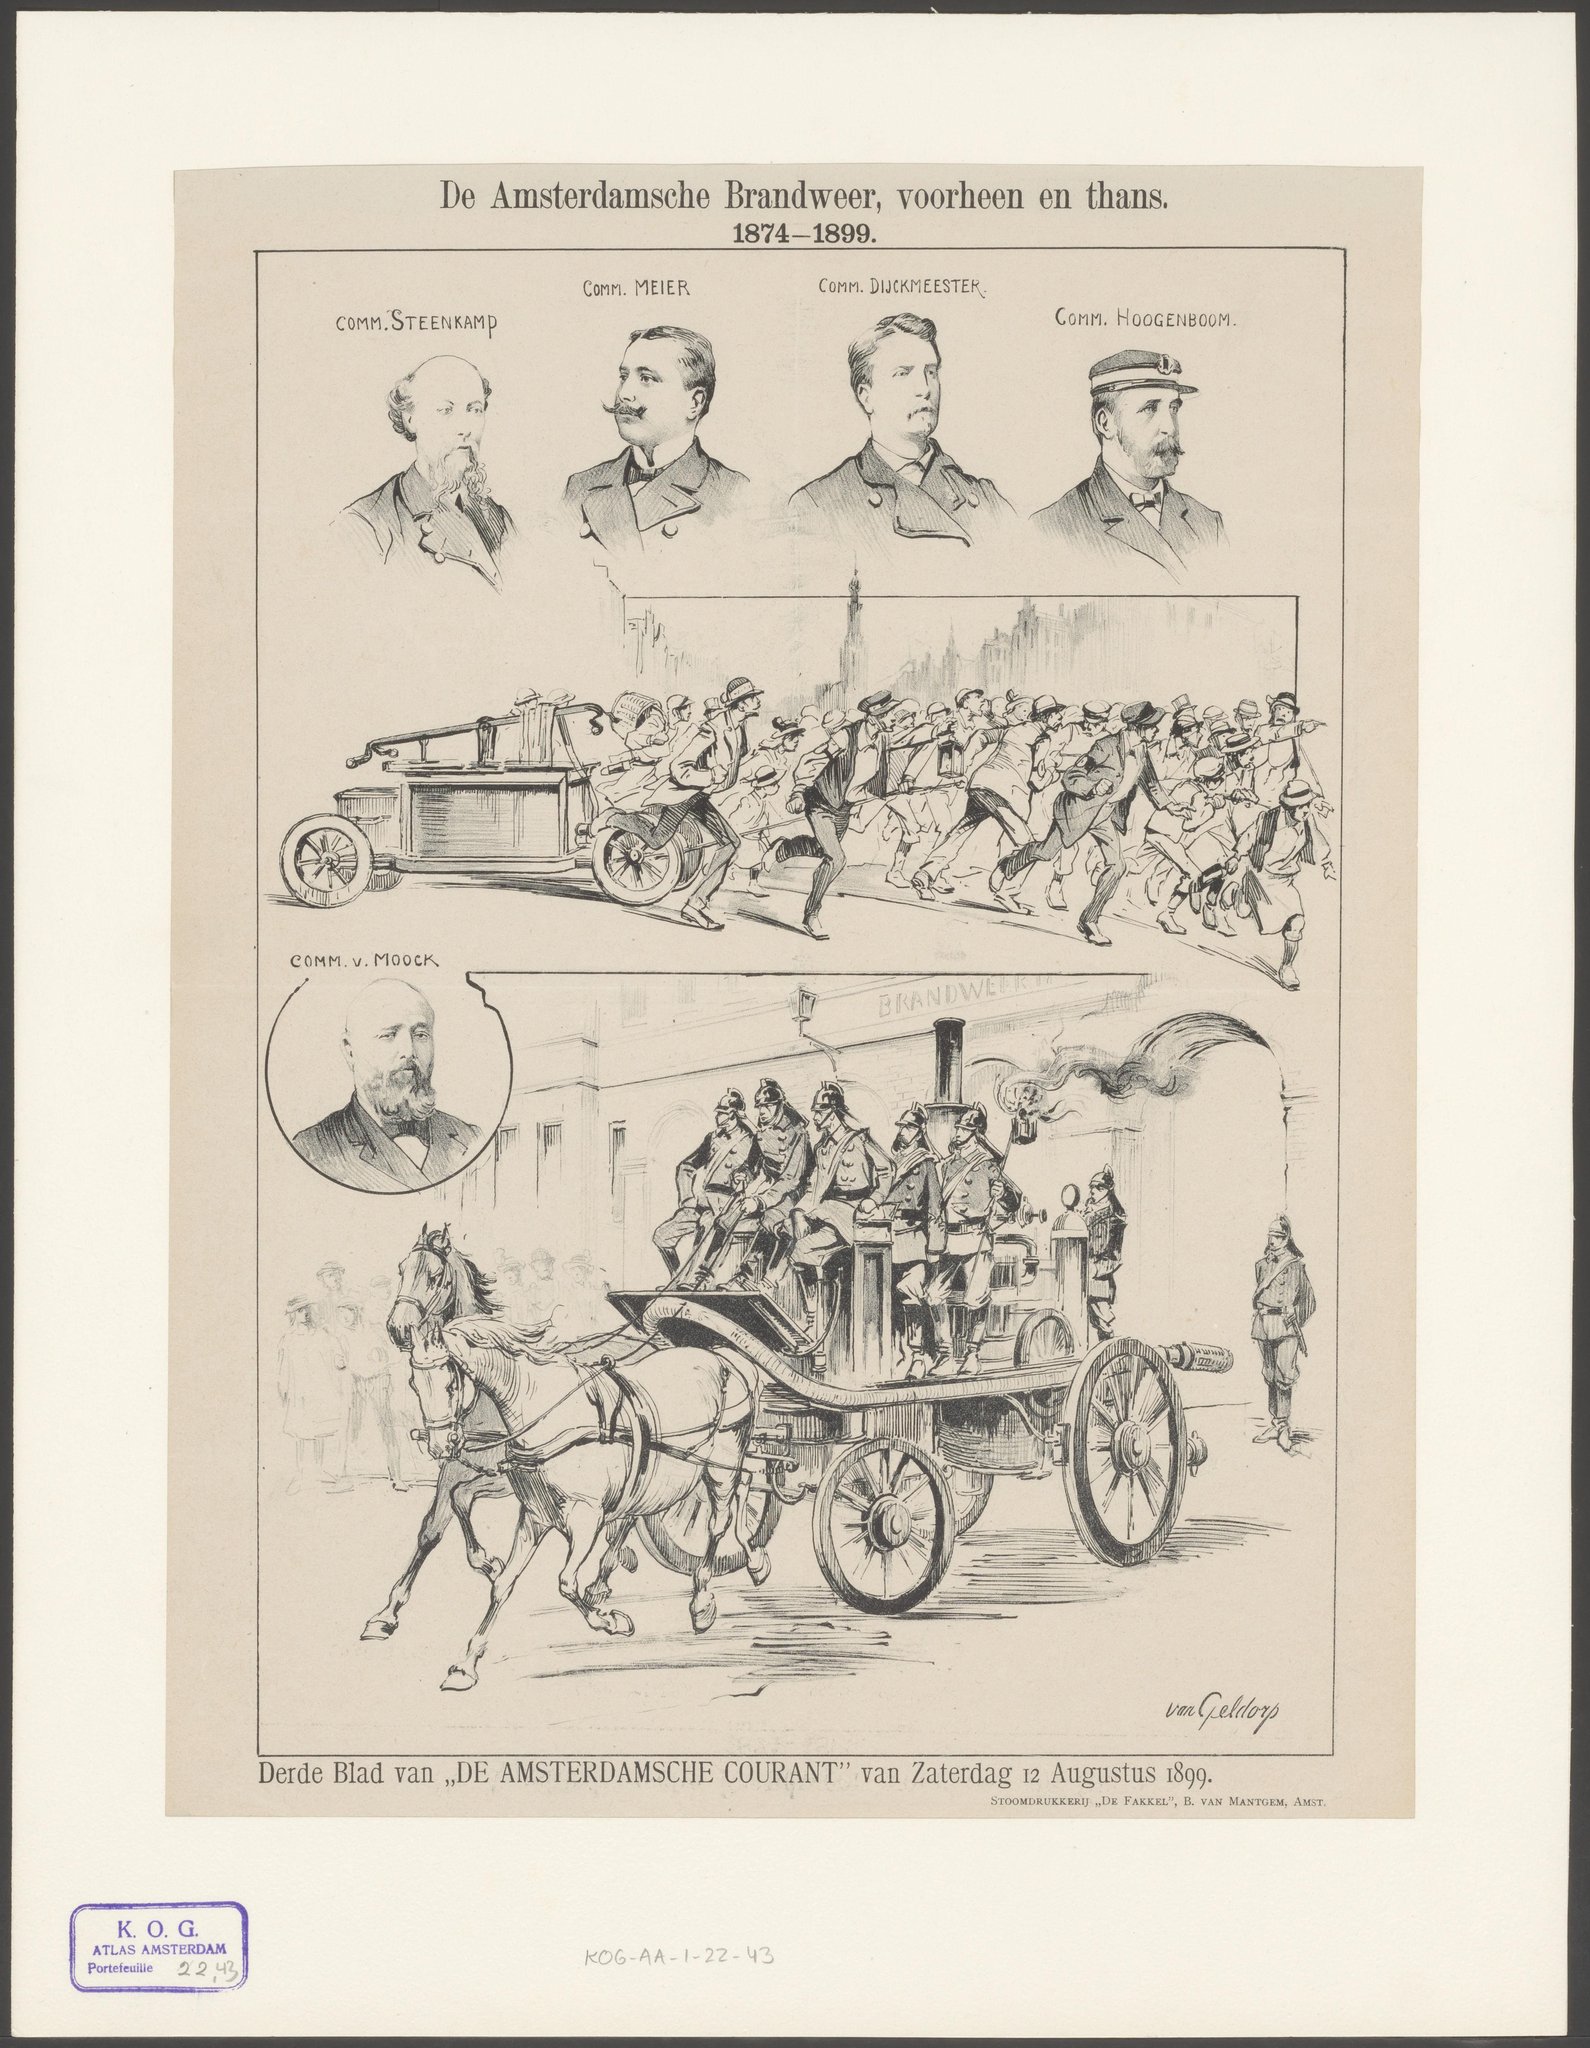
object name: print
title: De Amsterdamsche Brandweer, voorheen en thans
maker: petrus van geldorp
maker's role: draughtsman, print maker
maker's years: 1872-1939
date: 1899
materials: paper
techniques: letterpress printing, lithograph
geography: amsterdam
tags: historical persons, firemen, fire-engine, amsterdam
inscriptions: collector's mark: Lugt 1641b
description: Gepubliceerd als bijvoegsel van 'De Amsterdamsche Courant', 12 augustus 1899.